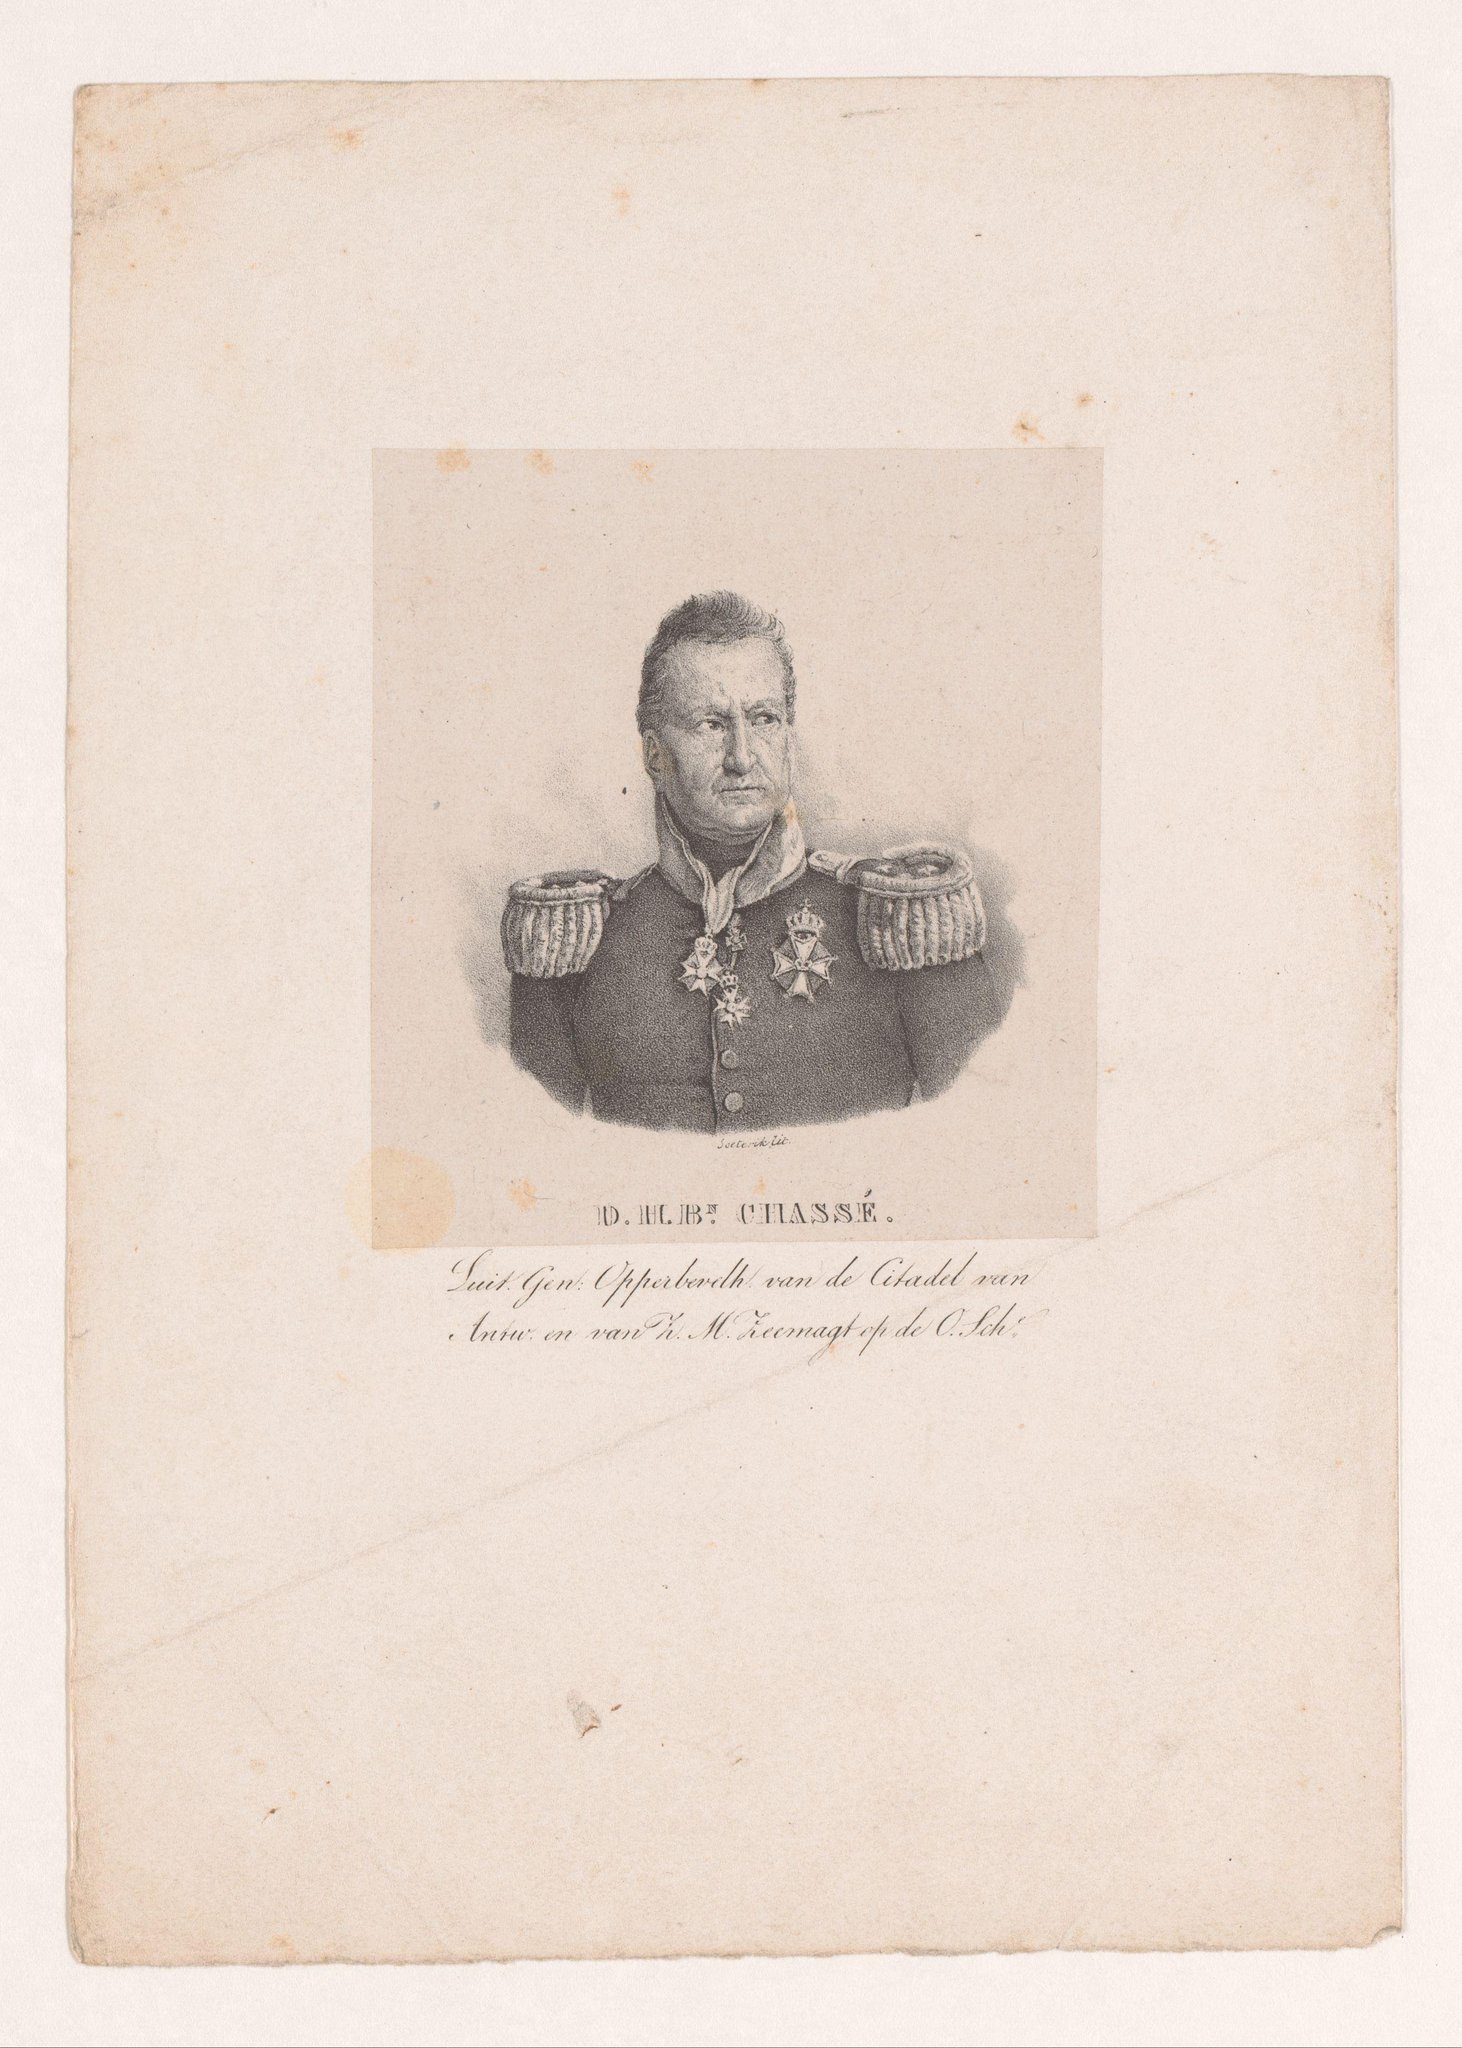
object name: print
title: D.H.Bn Chassé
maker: theodoor soeterik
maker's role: draughtsman, print maker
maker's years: 1810-1883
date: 1820-1849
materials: paper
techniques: lithograph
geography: utrecht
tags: david hendrik baron chassé, historical persons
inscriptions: collector's mark: Lugt 2228